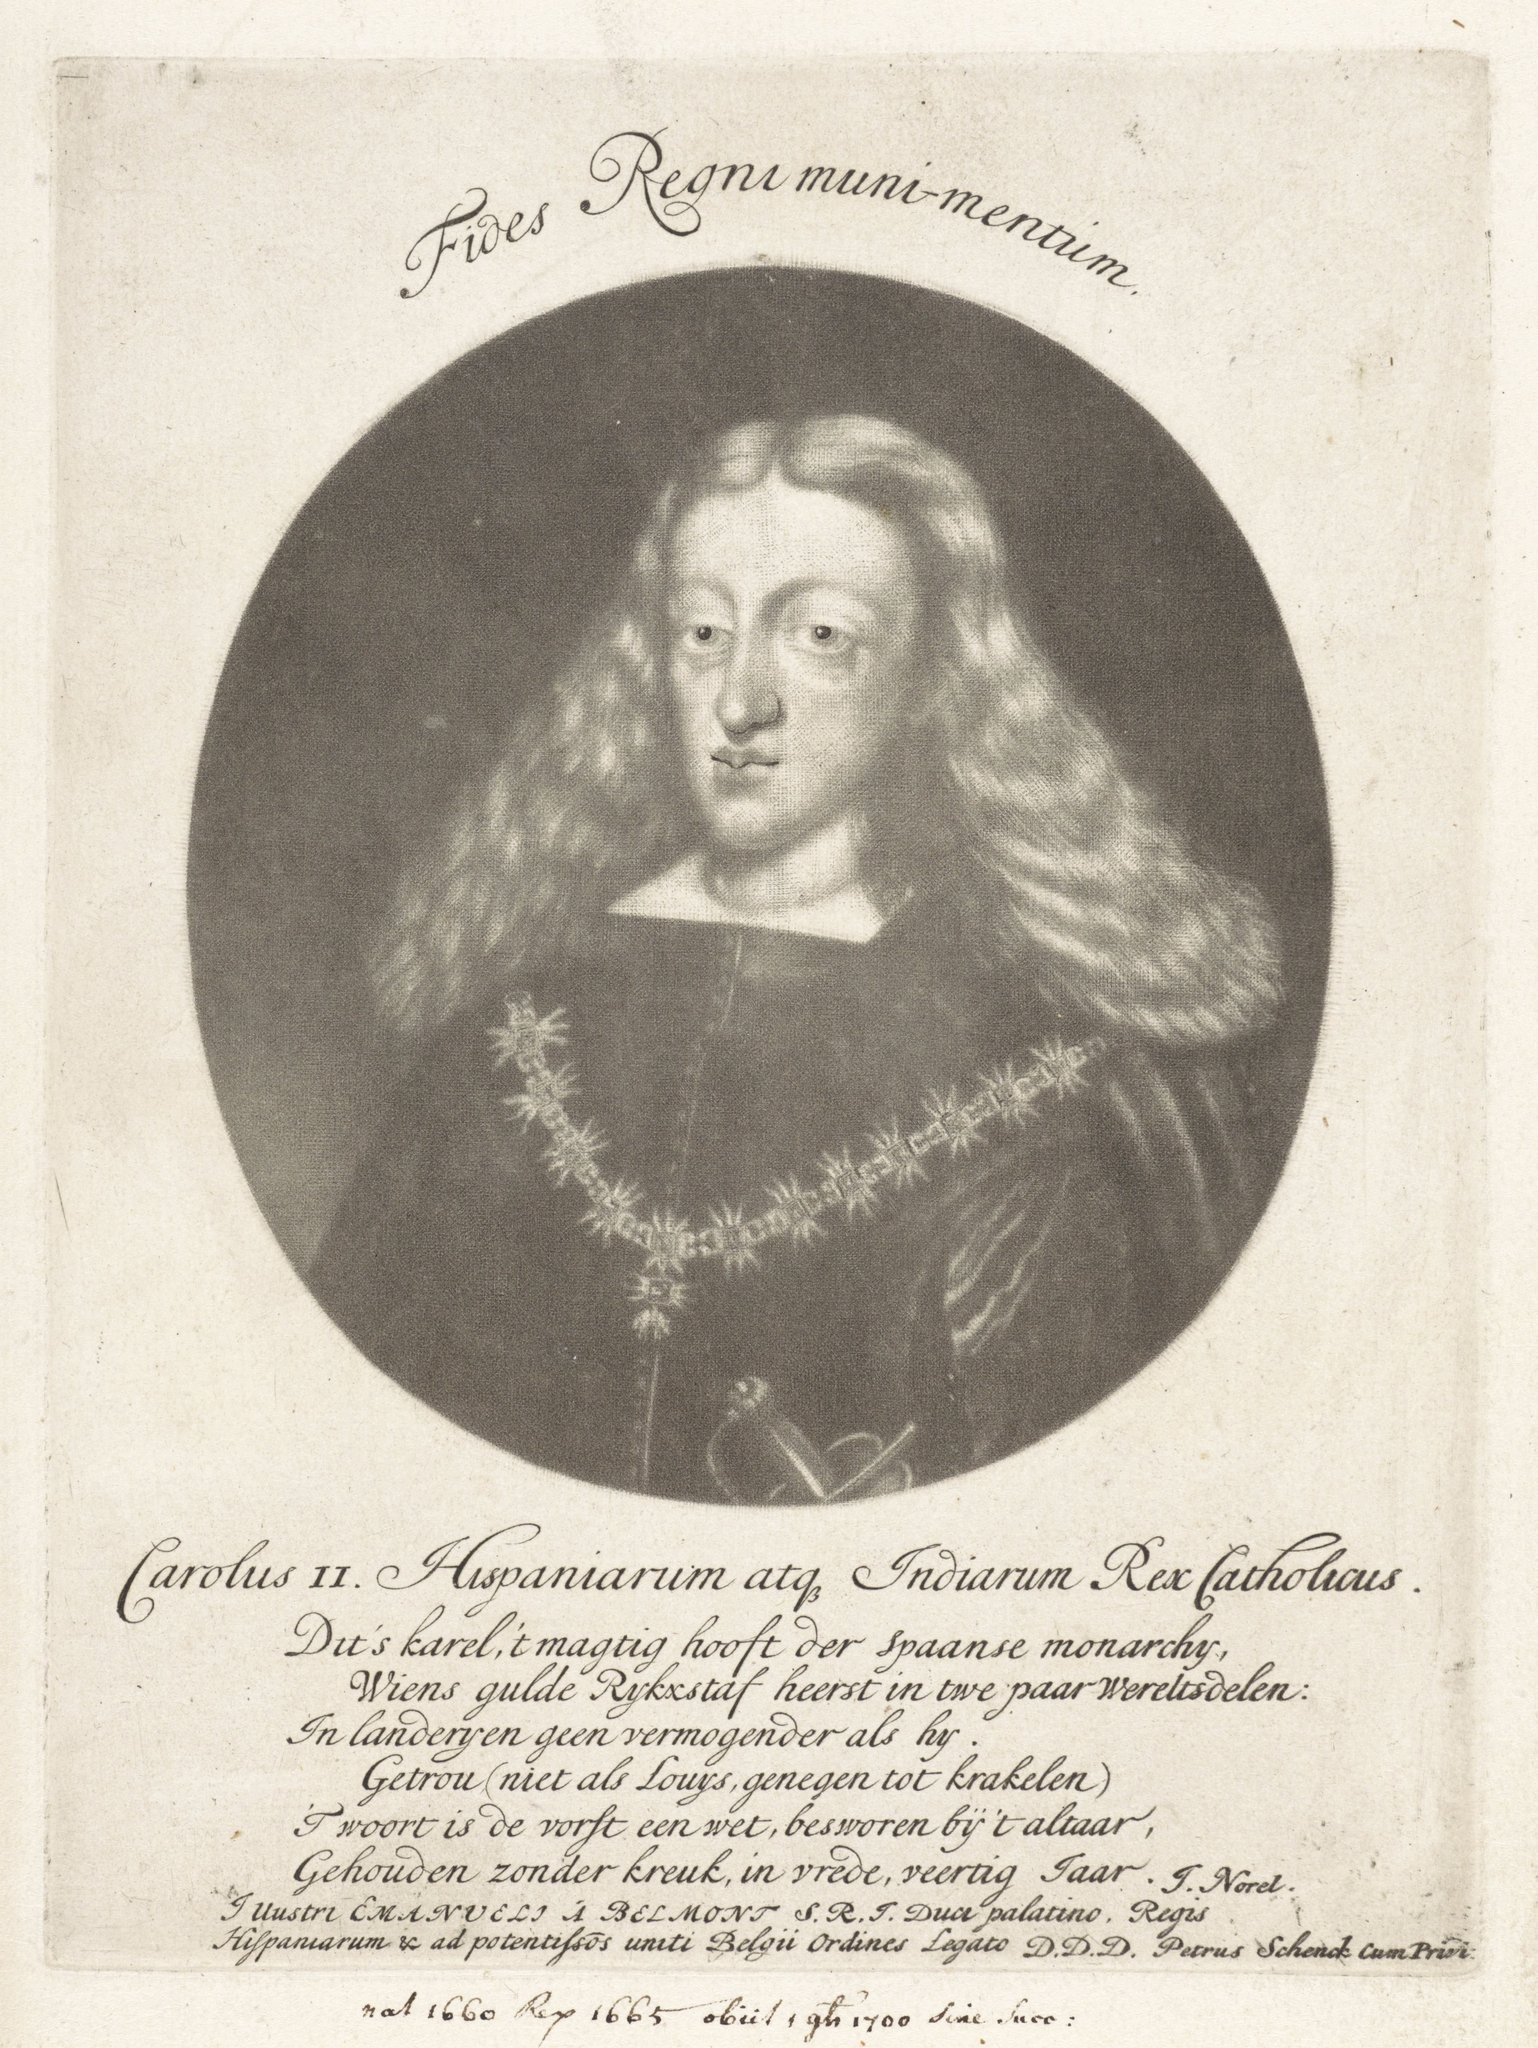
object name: print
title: Portret van Karel II, koning van Spanje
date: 1670-1713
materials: paper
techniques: engraving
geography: amsterdam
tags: karel ii (koning van spanje), knighthood order of the golden fleece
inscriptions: collector's mark: Lugt 2228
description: Karel II, koning van Spanje op jonge leeftijd, met om de hals een keten met het ordeteken van het Gulden Vlies.